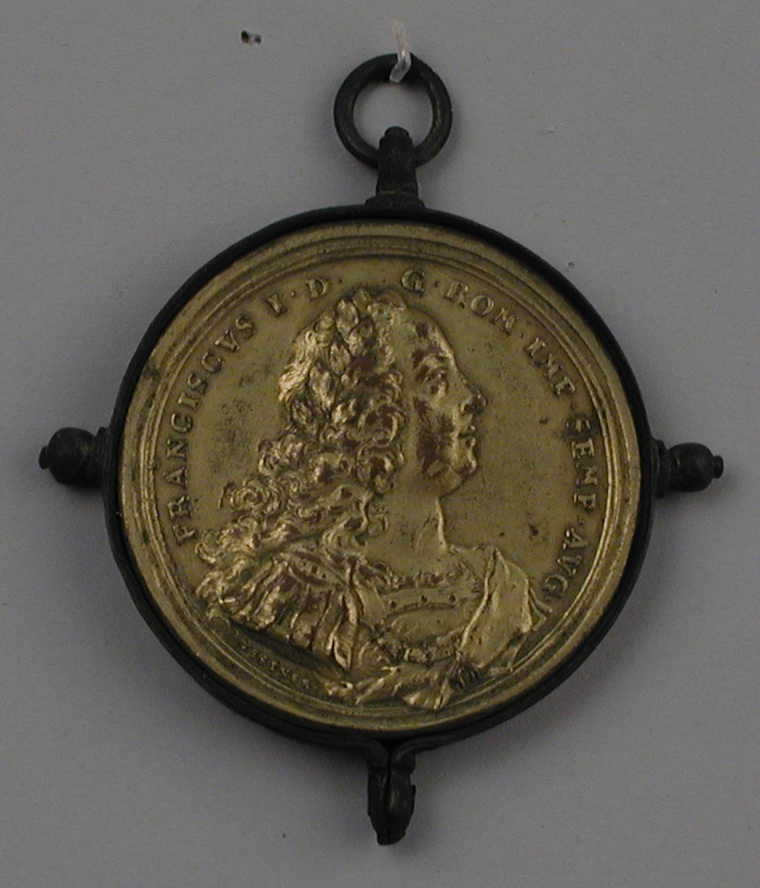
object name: medal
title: Francis I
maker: georg wilhelm vestner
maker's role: artist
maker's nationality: german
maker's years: 1677-1740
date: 1701-1800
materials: gilt bronze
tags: men,profiles